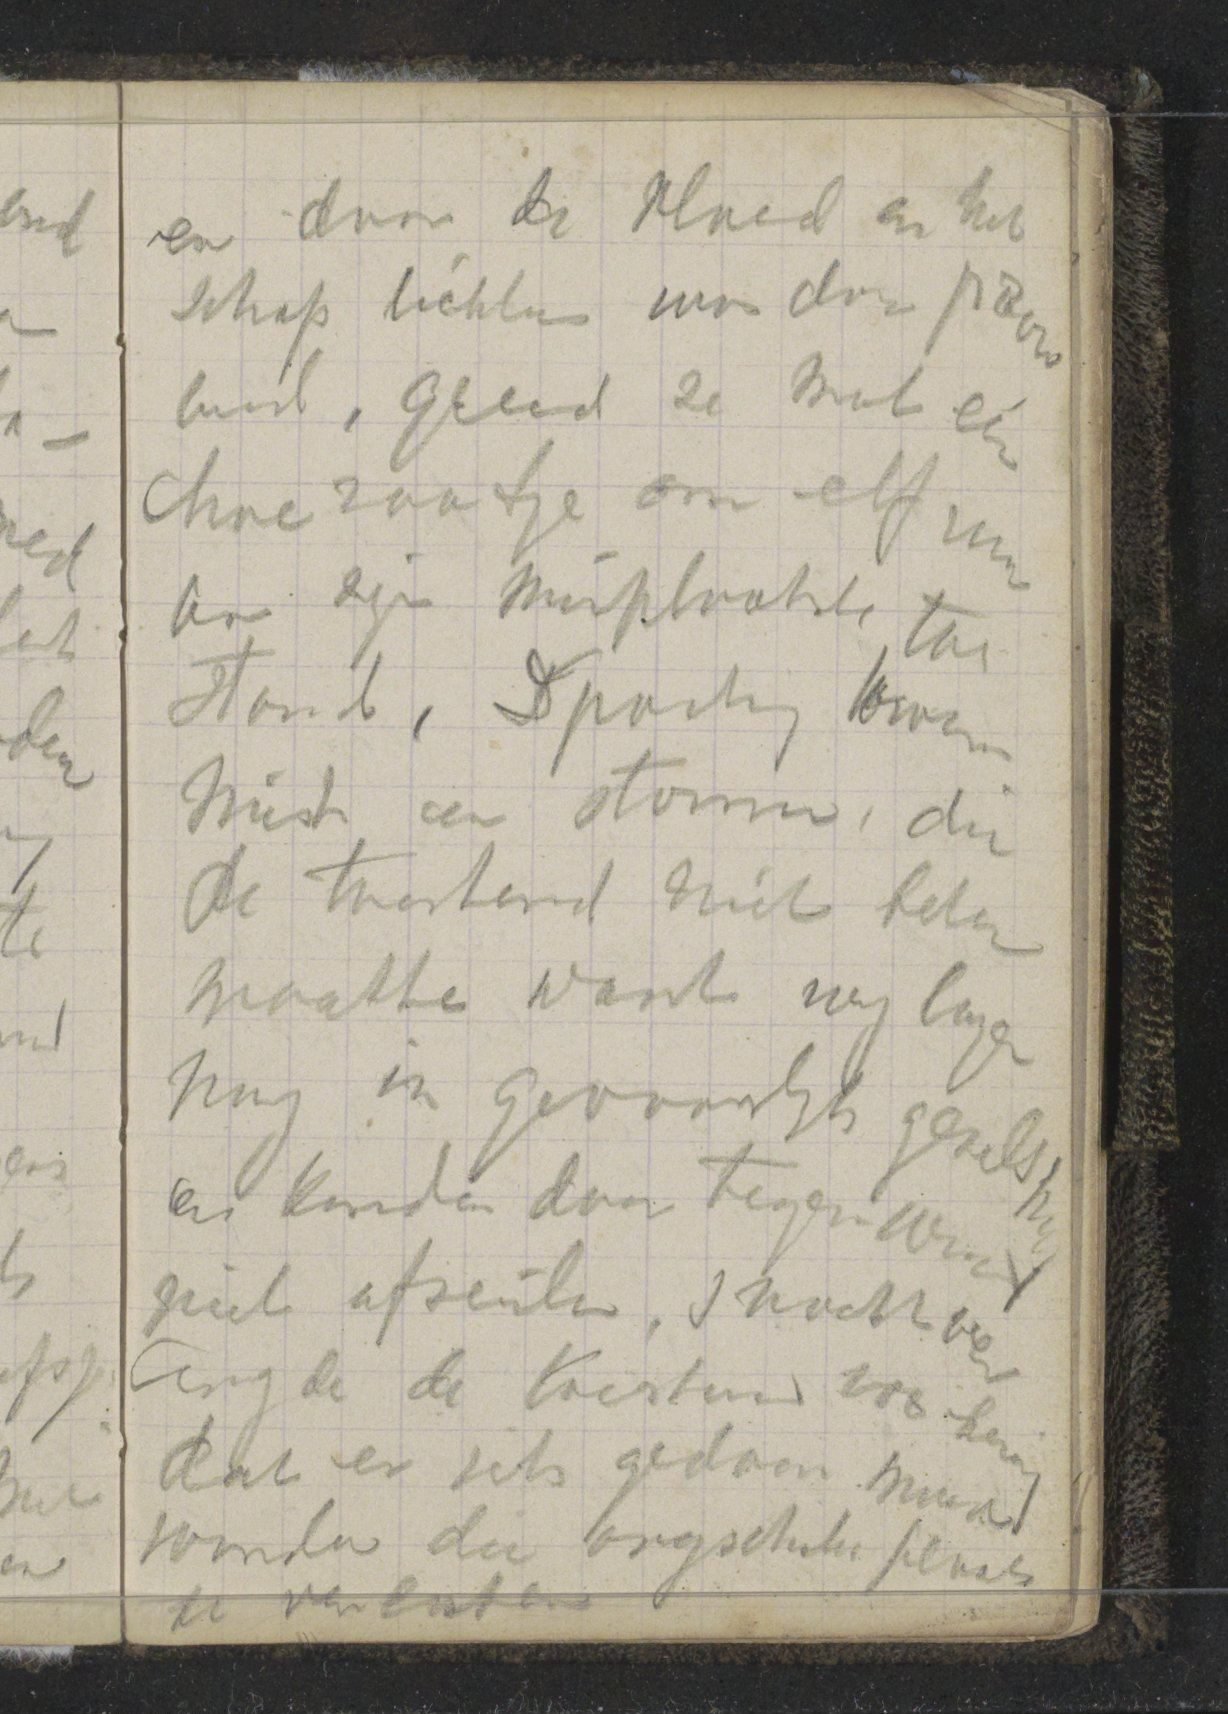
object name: sketchbook leaf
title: Reisverslag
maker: louis apol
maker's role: draughtsman, painter, print maker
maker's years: 1850-1936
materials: pencil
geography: novaya zemlya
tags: nova zembla expedities 1880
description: Blad 96 recto uit een schetsboek met 110 bladen betekend tijdens de expeditie naar Nova Zembla in 1880.